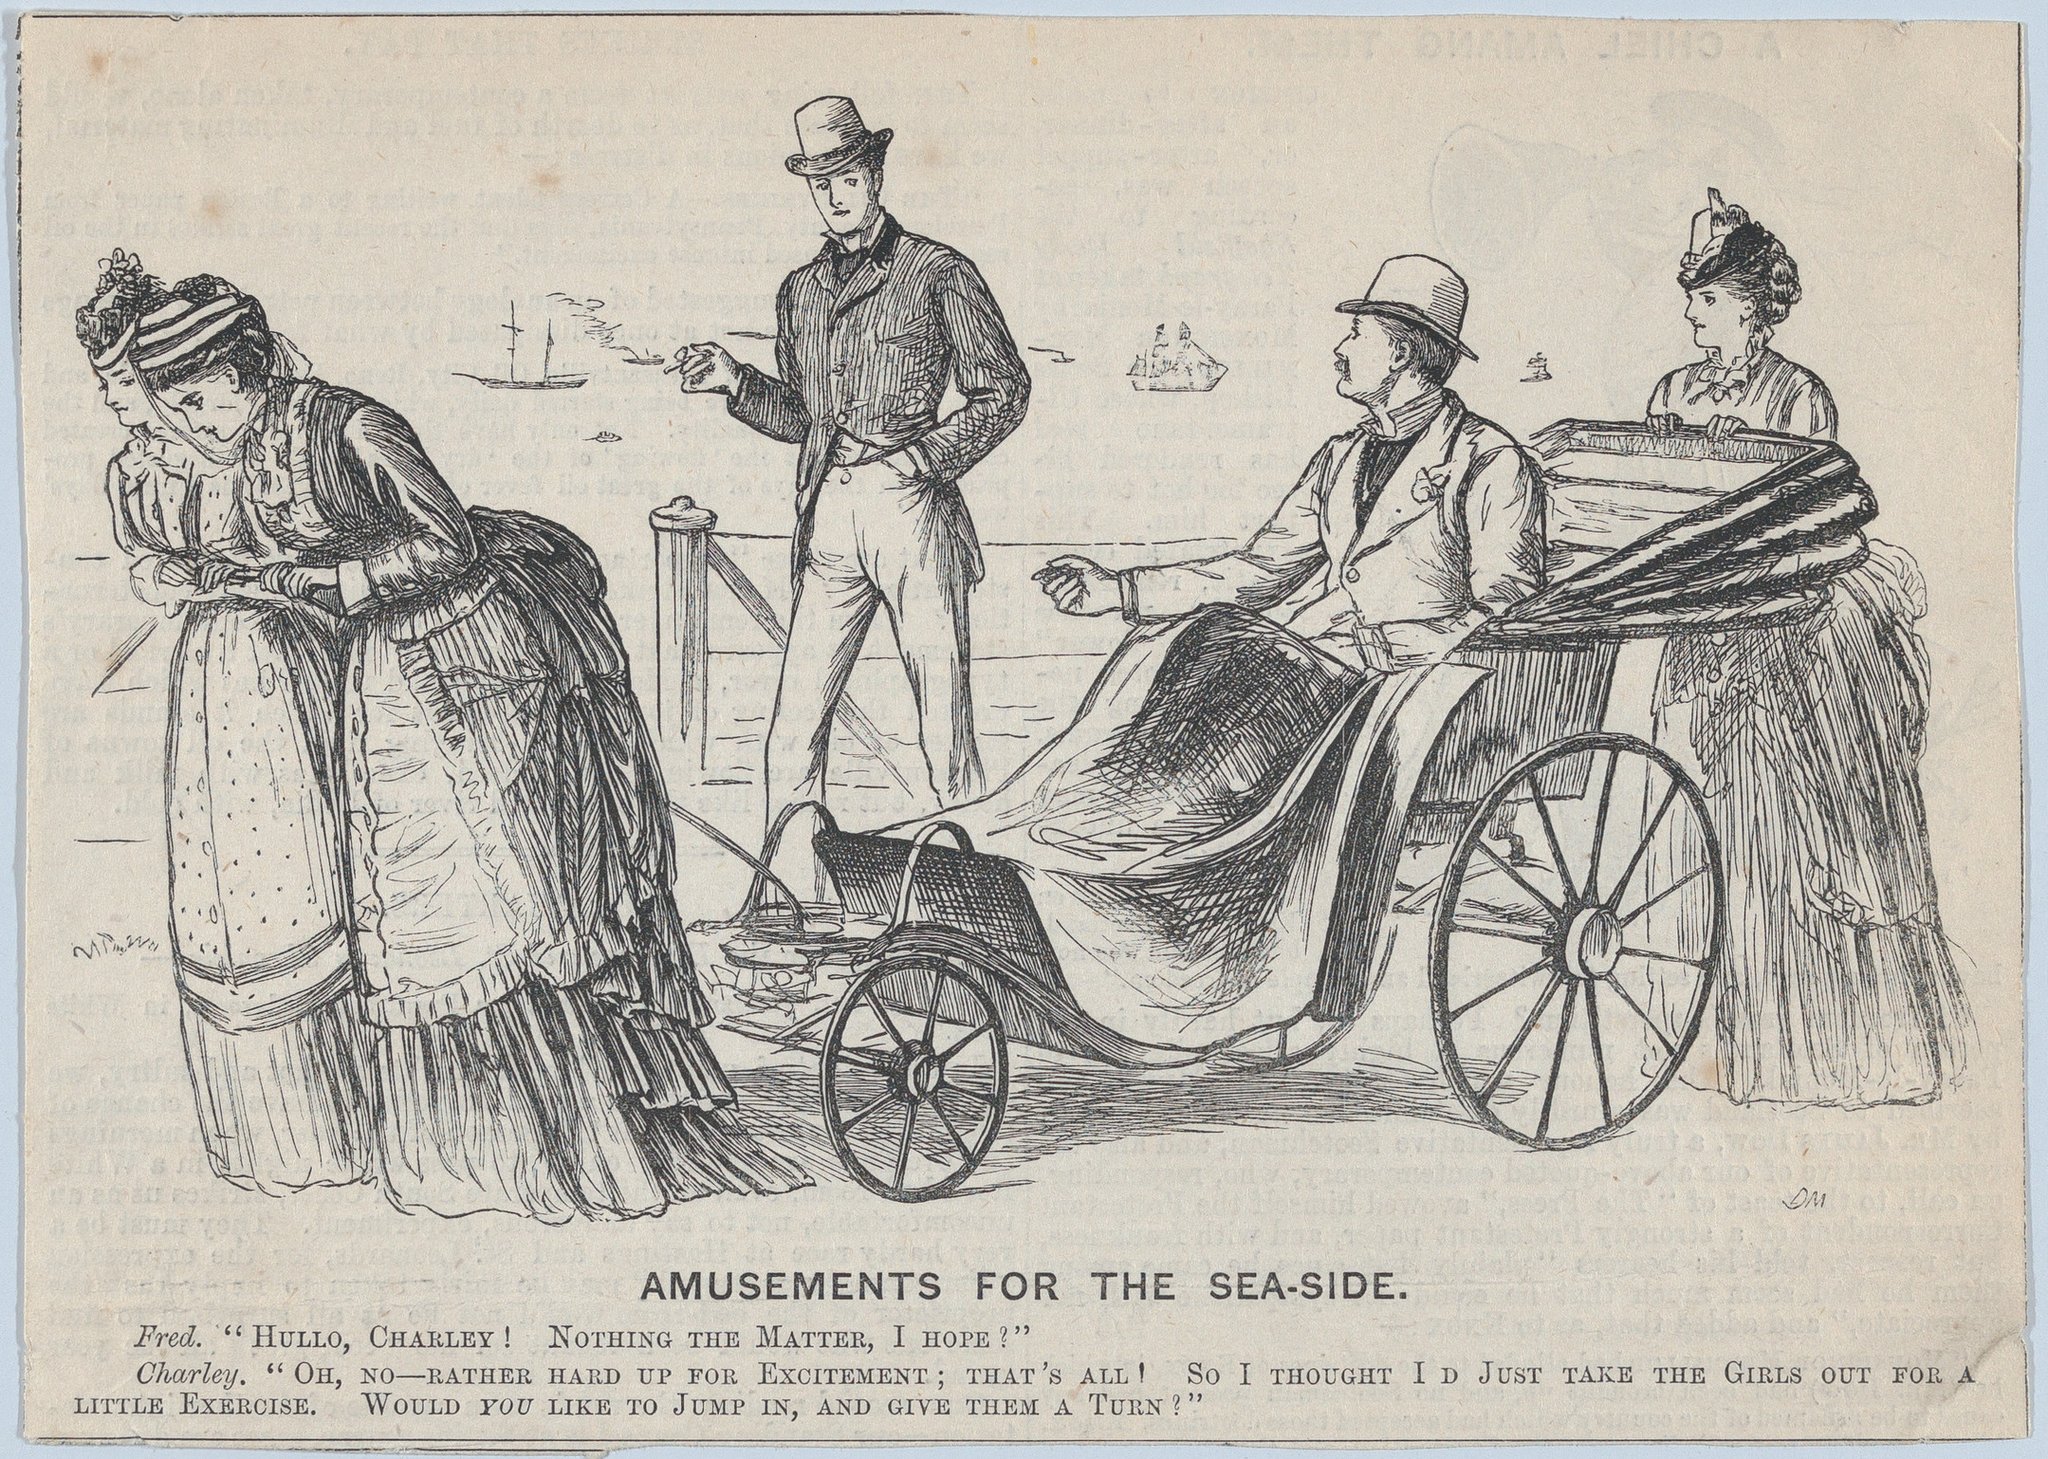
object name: print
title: A Chiel Among Them (recto); Amusements for the Sea-side (verso)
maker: george du maurier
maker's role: artist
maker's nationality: british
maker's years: 1834-1896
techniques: engraving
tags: men,women,carriages,caricature